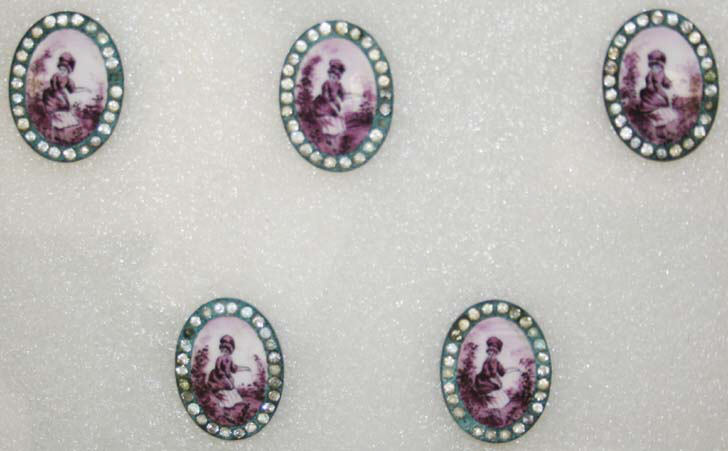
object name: button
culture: french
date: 1850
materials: enamel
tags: women